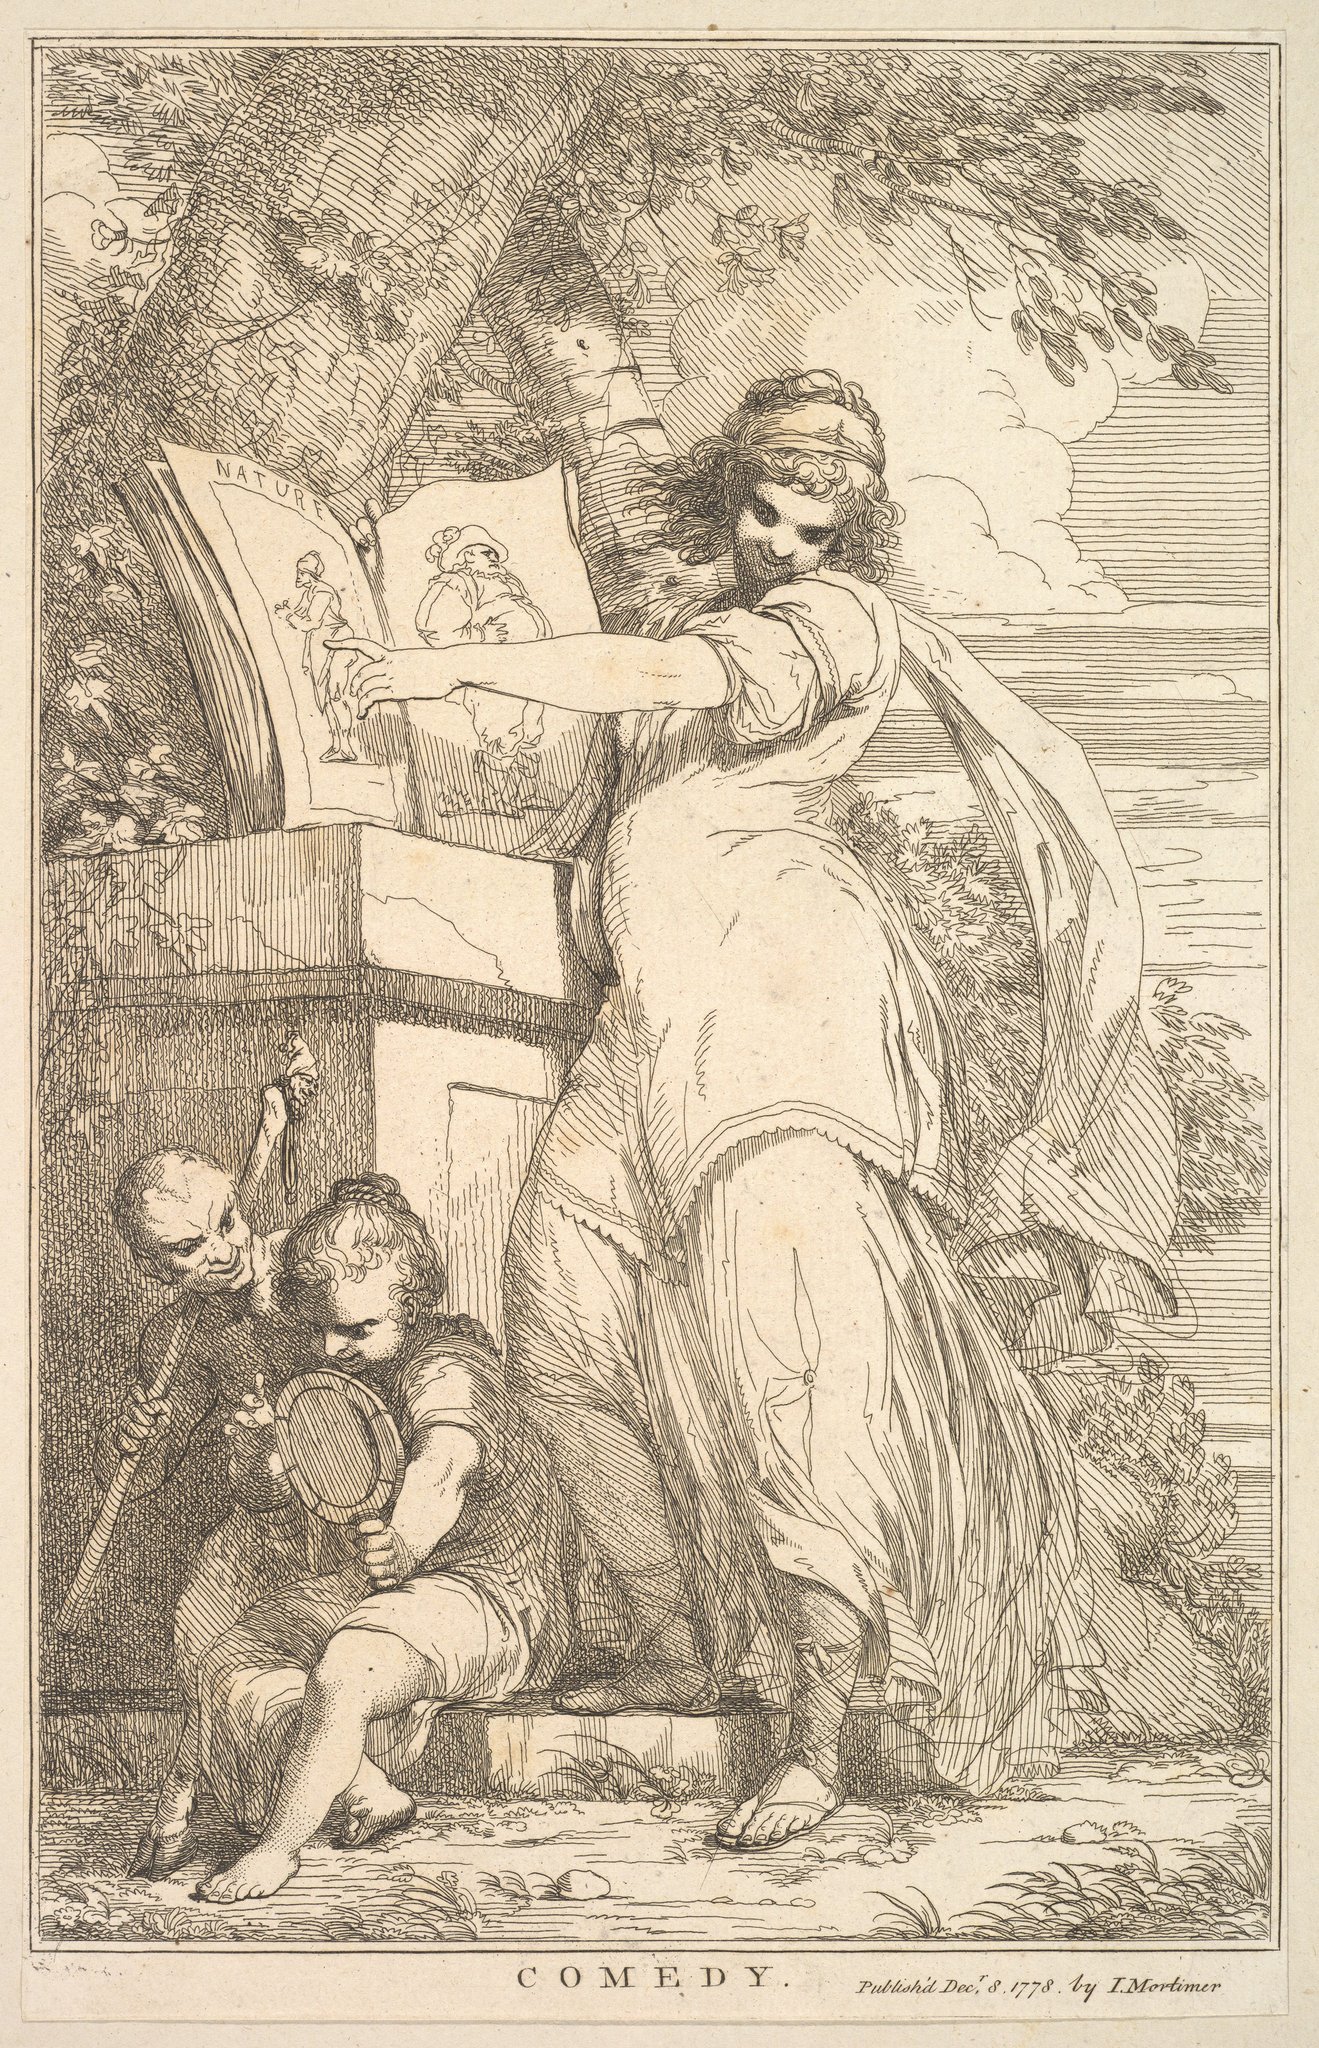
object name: print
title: Comedy, from "Fifteen Etchings Dedicated to Sir Joshua Reynolds"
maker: john hamilton mortimer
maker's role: artist and publisher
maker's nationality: british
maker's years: 1740-1779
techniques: etching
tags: girls,women